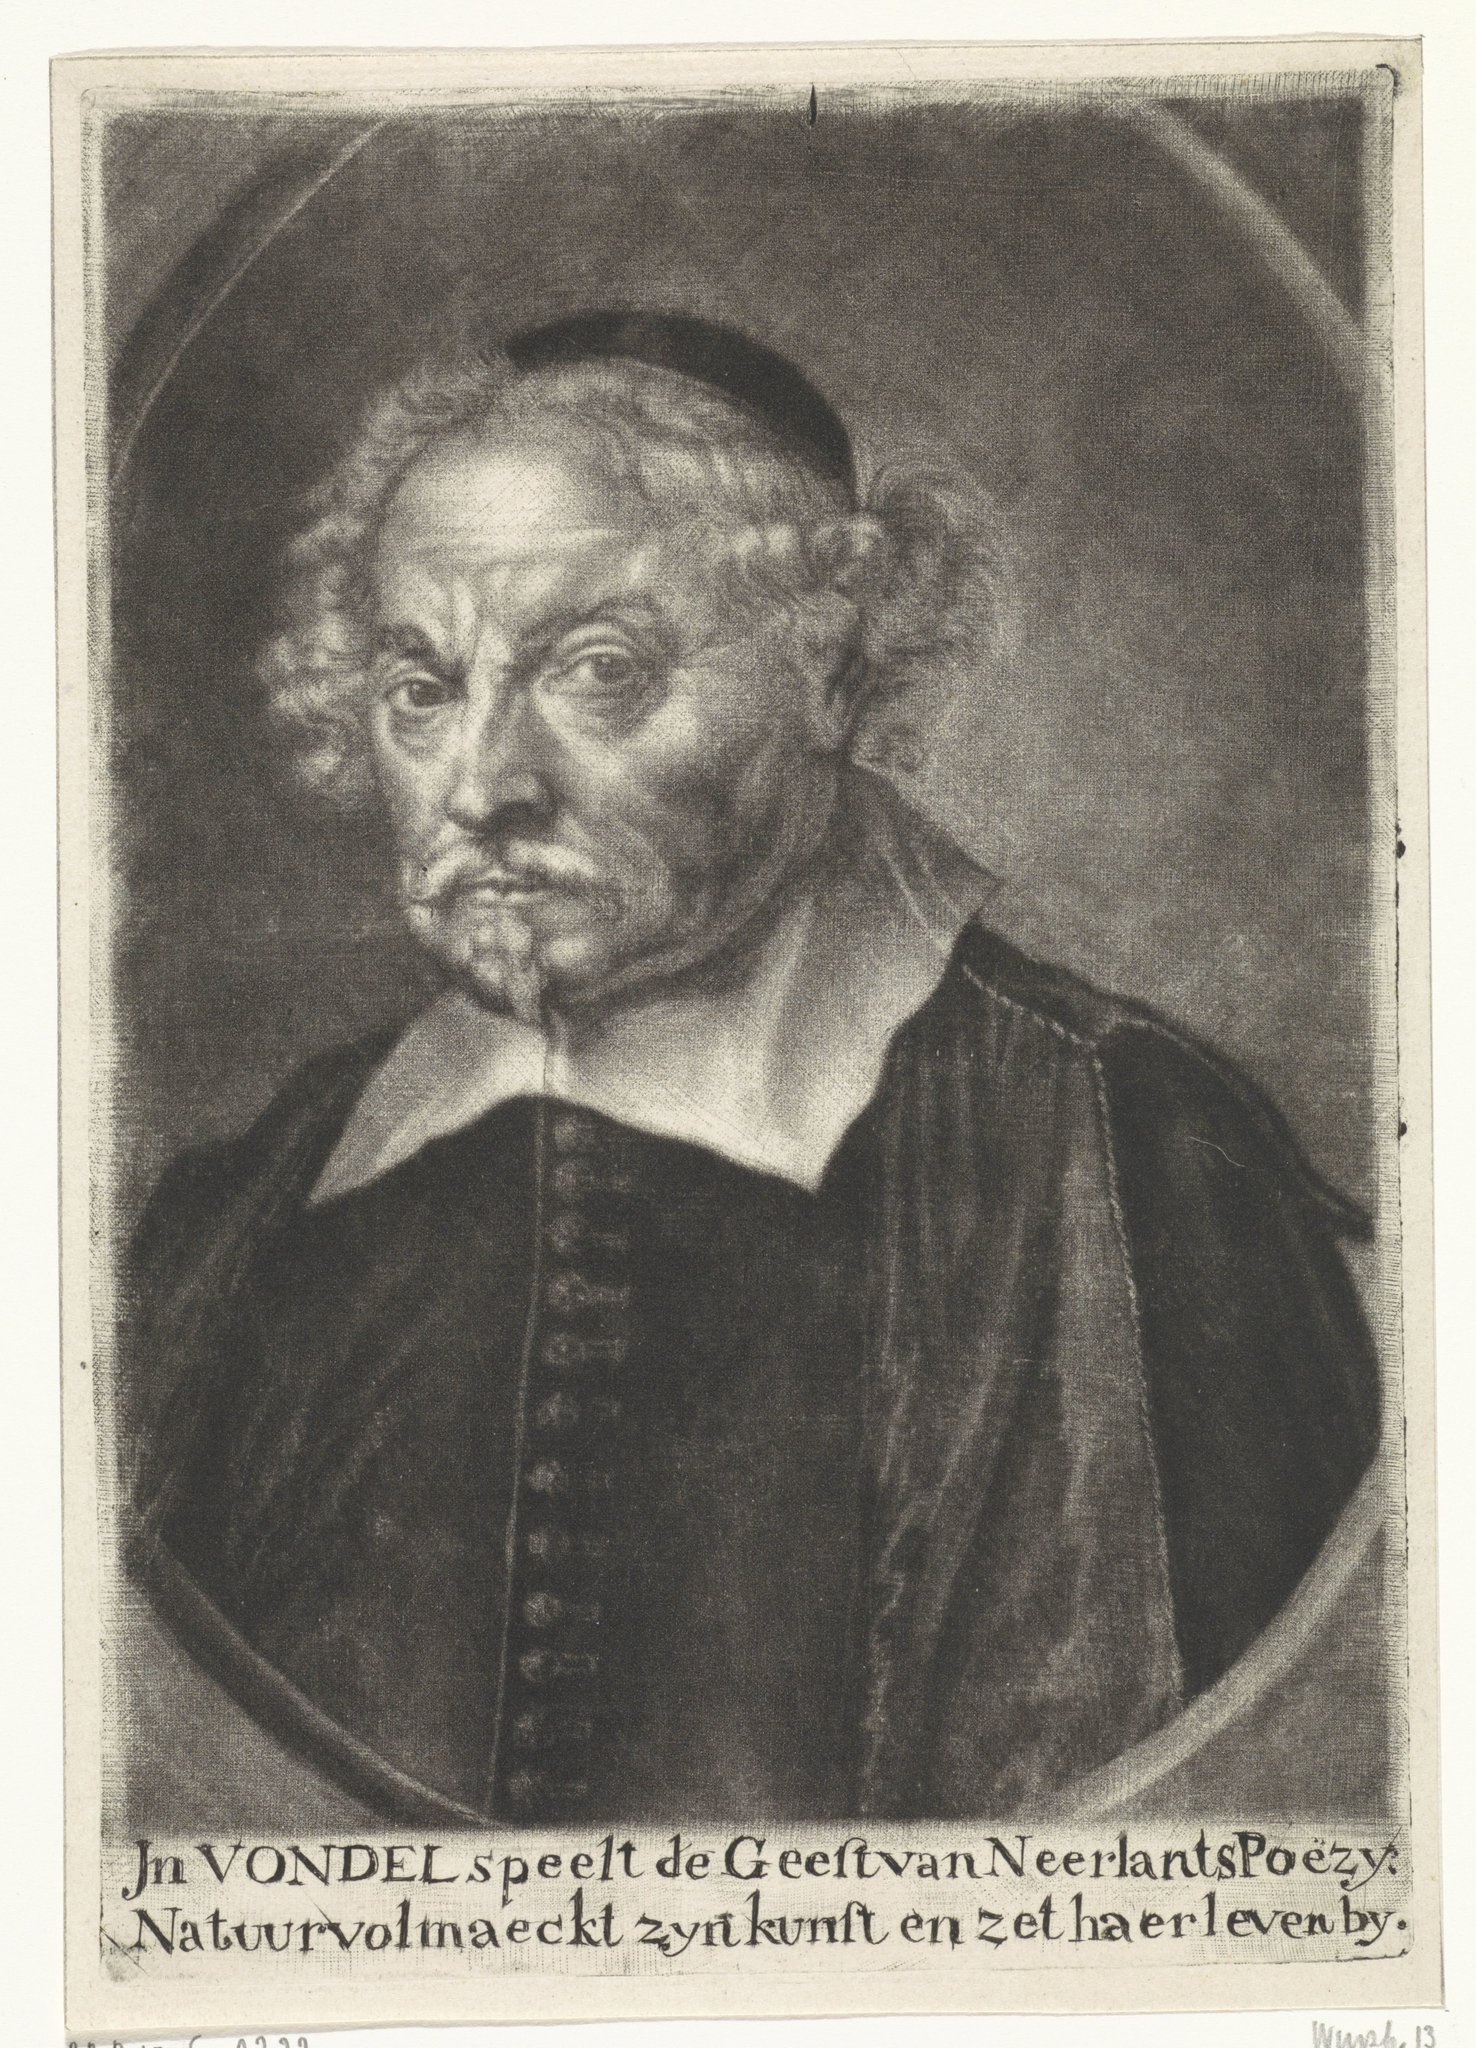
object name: print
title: Portret van Joost van den Vondel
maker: johannes de groot (ii)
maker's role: painter, print maker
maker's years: 1688-1796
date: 1722-1745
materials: paper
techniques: engraving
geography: northern netherlands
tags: cologne, amsterdam, joost van den vondel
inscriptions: collector's mark: Lugt 2228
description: De schrijver en dichter Joost van den Vondel.